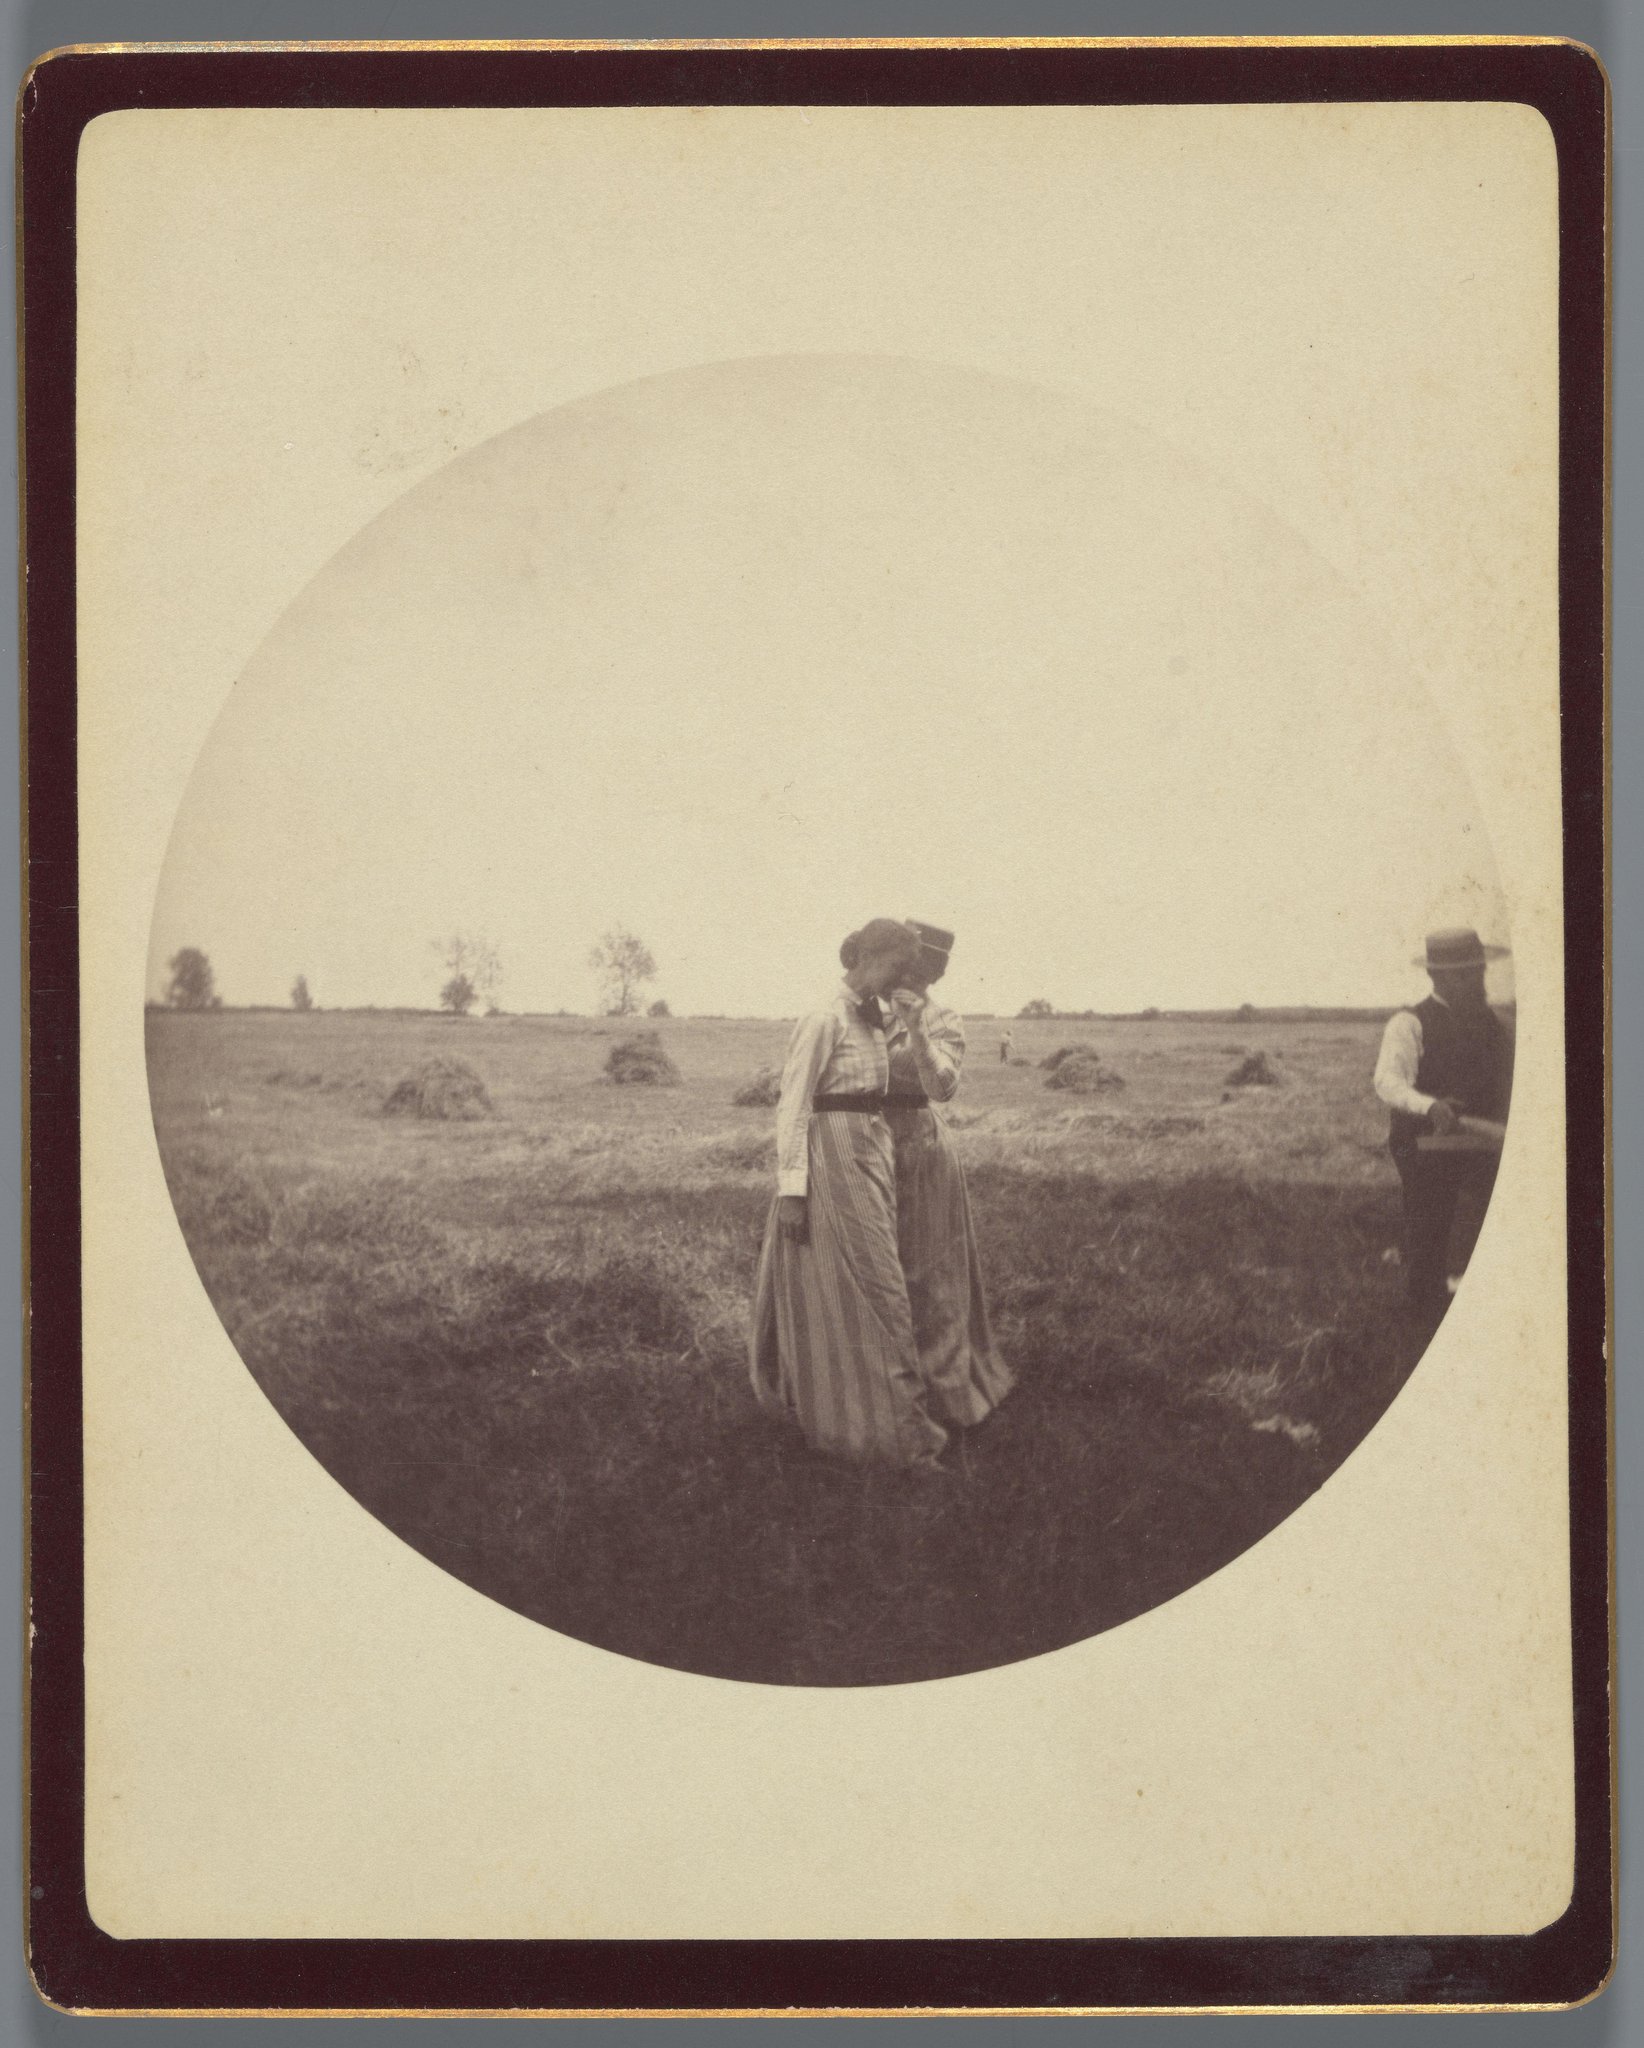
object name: photograph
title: Aanleg Central Mexican Railway april 1890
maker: Anonymous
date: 1804-1890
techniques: photography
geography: united states